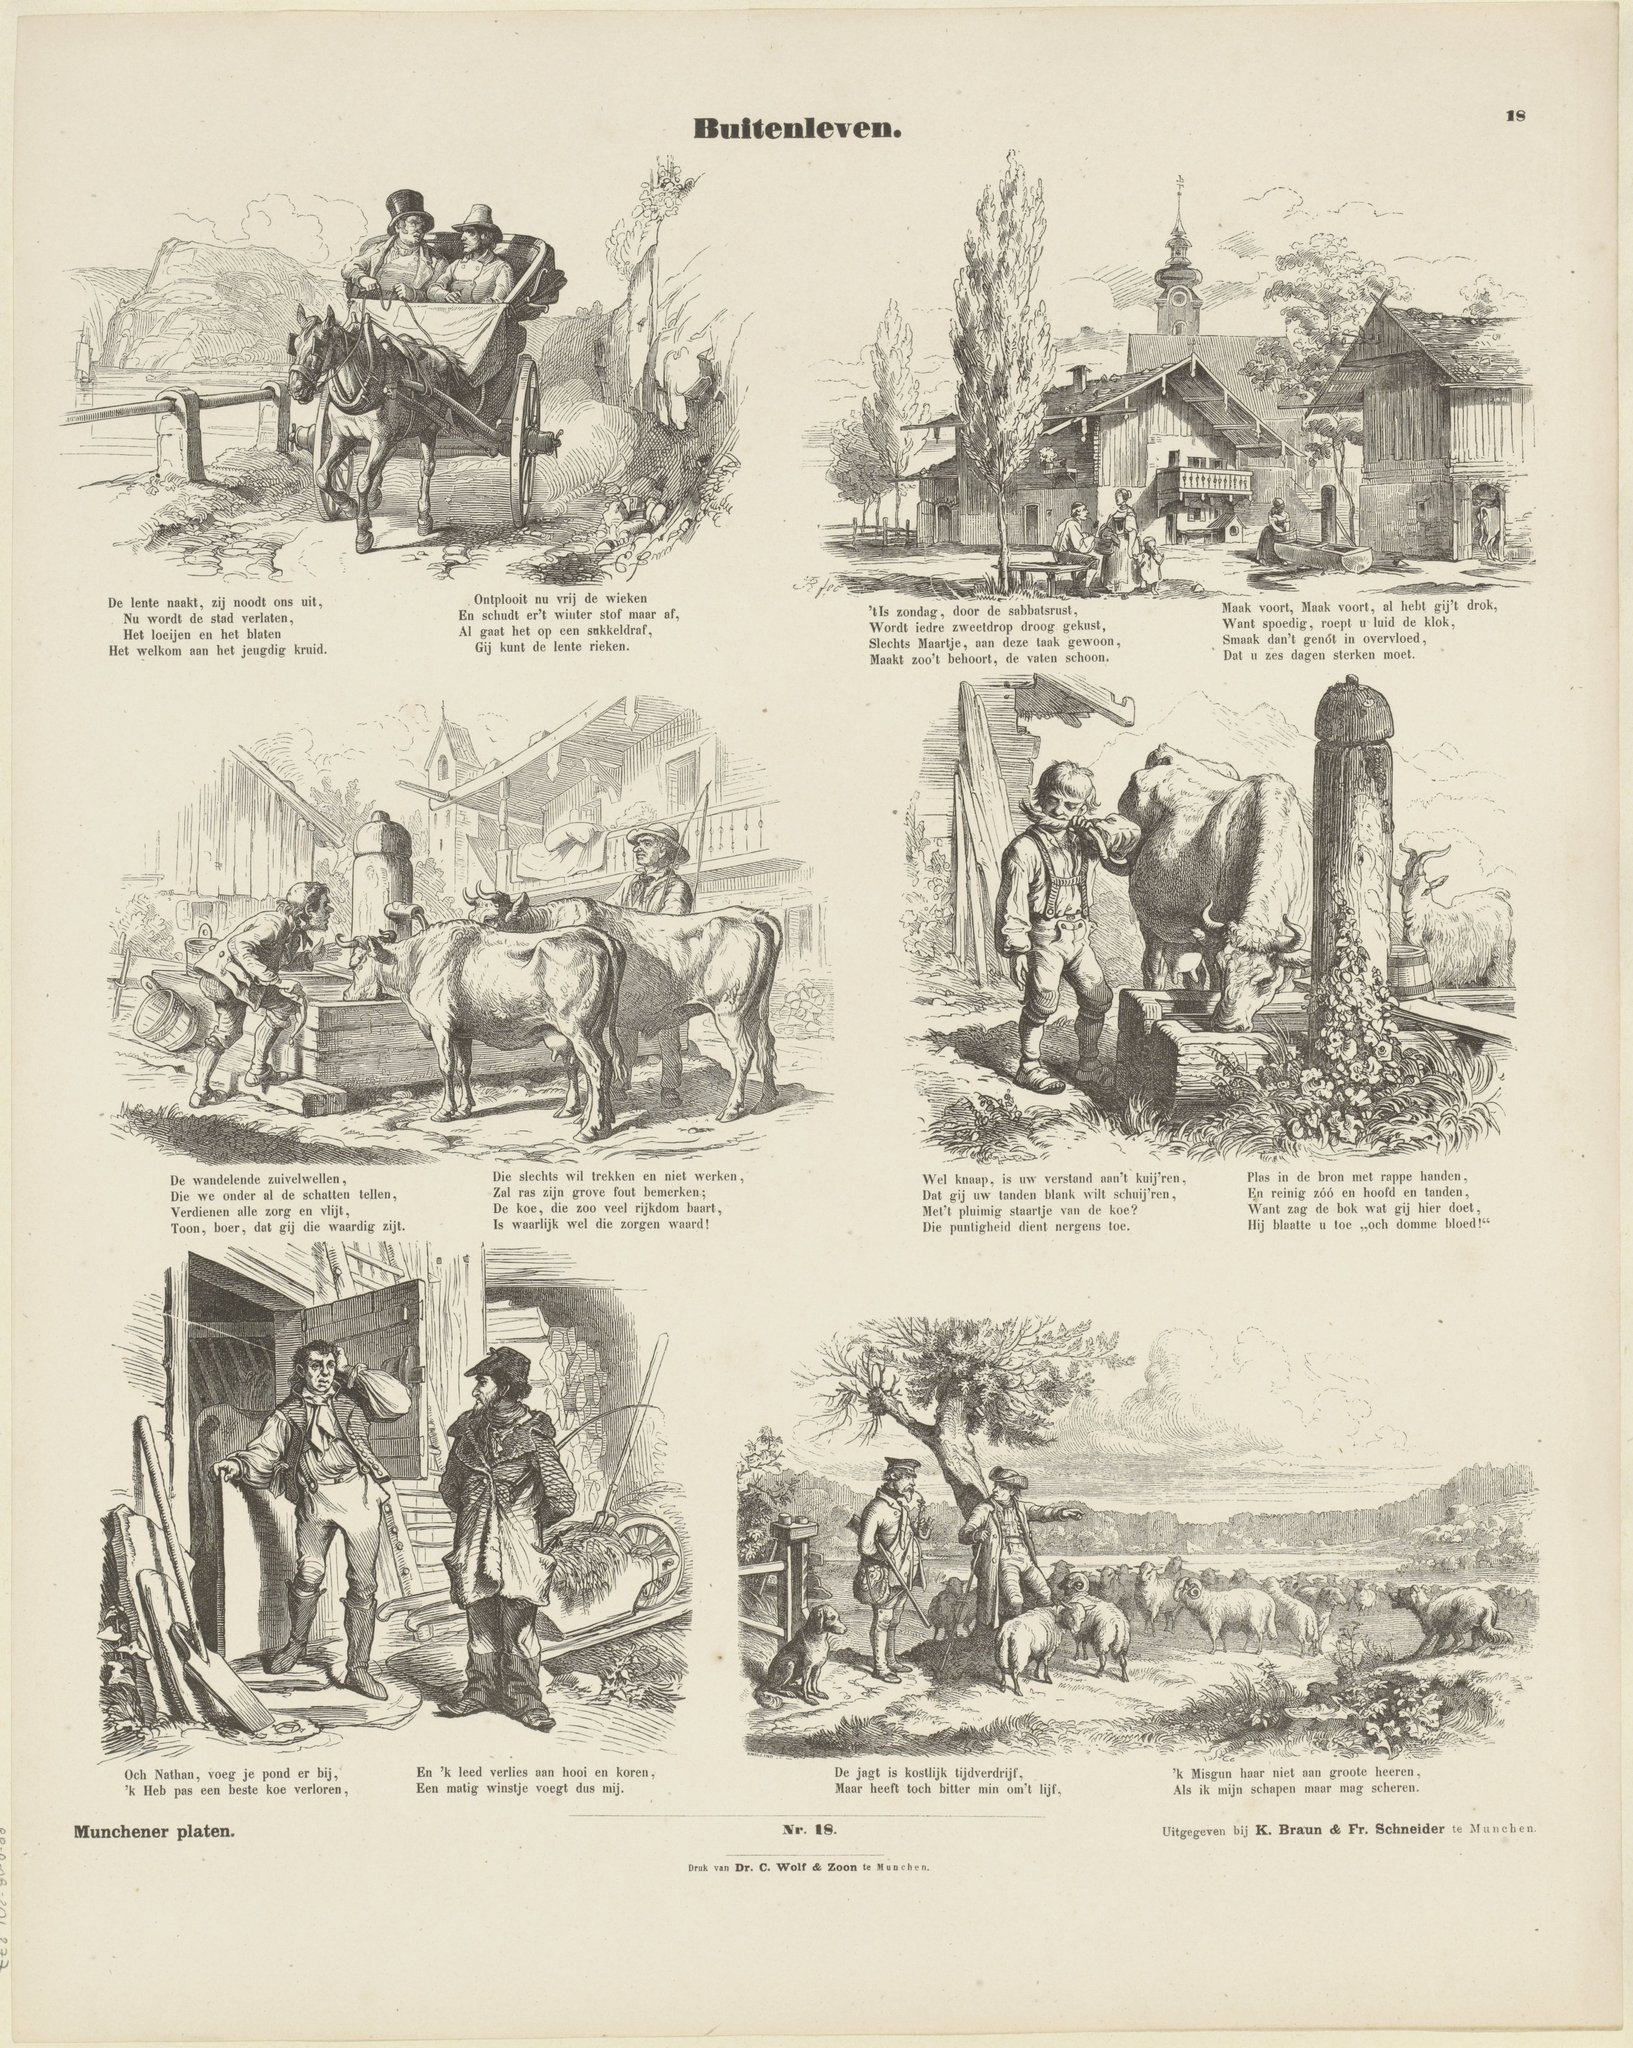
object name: print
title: Buitenleven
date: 1843-1920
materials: paper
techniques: letterpress printing, engraving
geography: germany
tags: cow, herding, herdsman, herdswoman, shepherd, shepherdess, cowherd, etc., herd, flock, rural life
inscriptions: collector's mark: Lugt 2760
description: Blad met 6 voorstellingen van het buitenleven, waaronder twee mannen in een rijtuig in de natuur en een herder met zijn schapen in een weiland. Onder elke afbeelding een vers in twee kolommen. Genummerd midden onder: Nr. 18. Genummerd rechtsboven: 18.